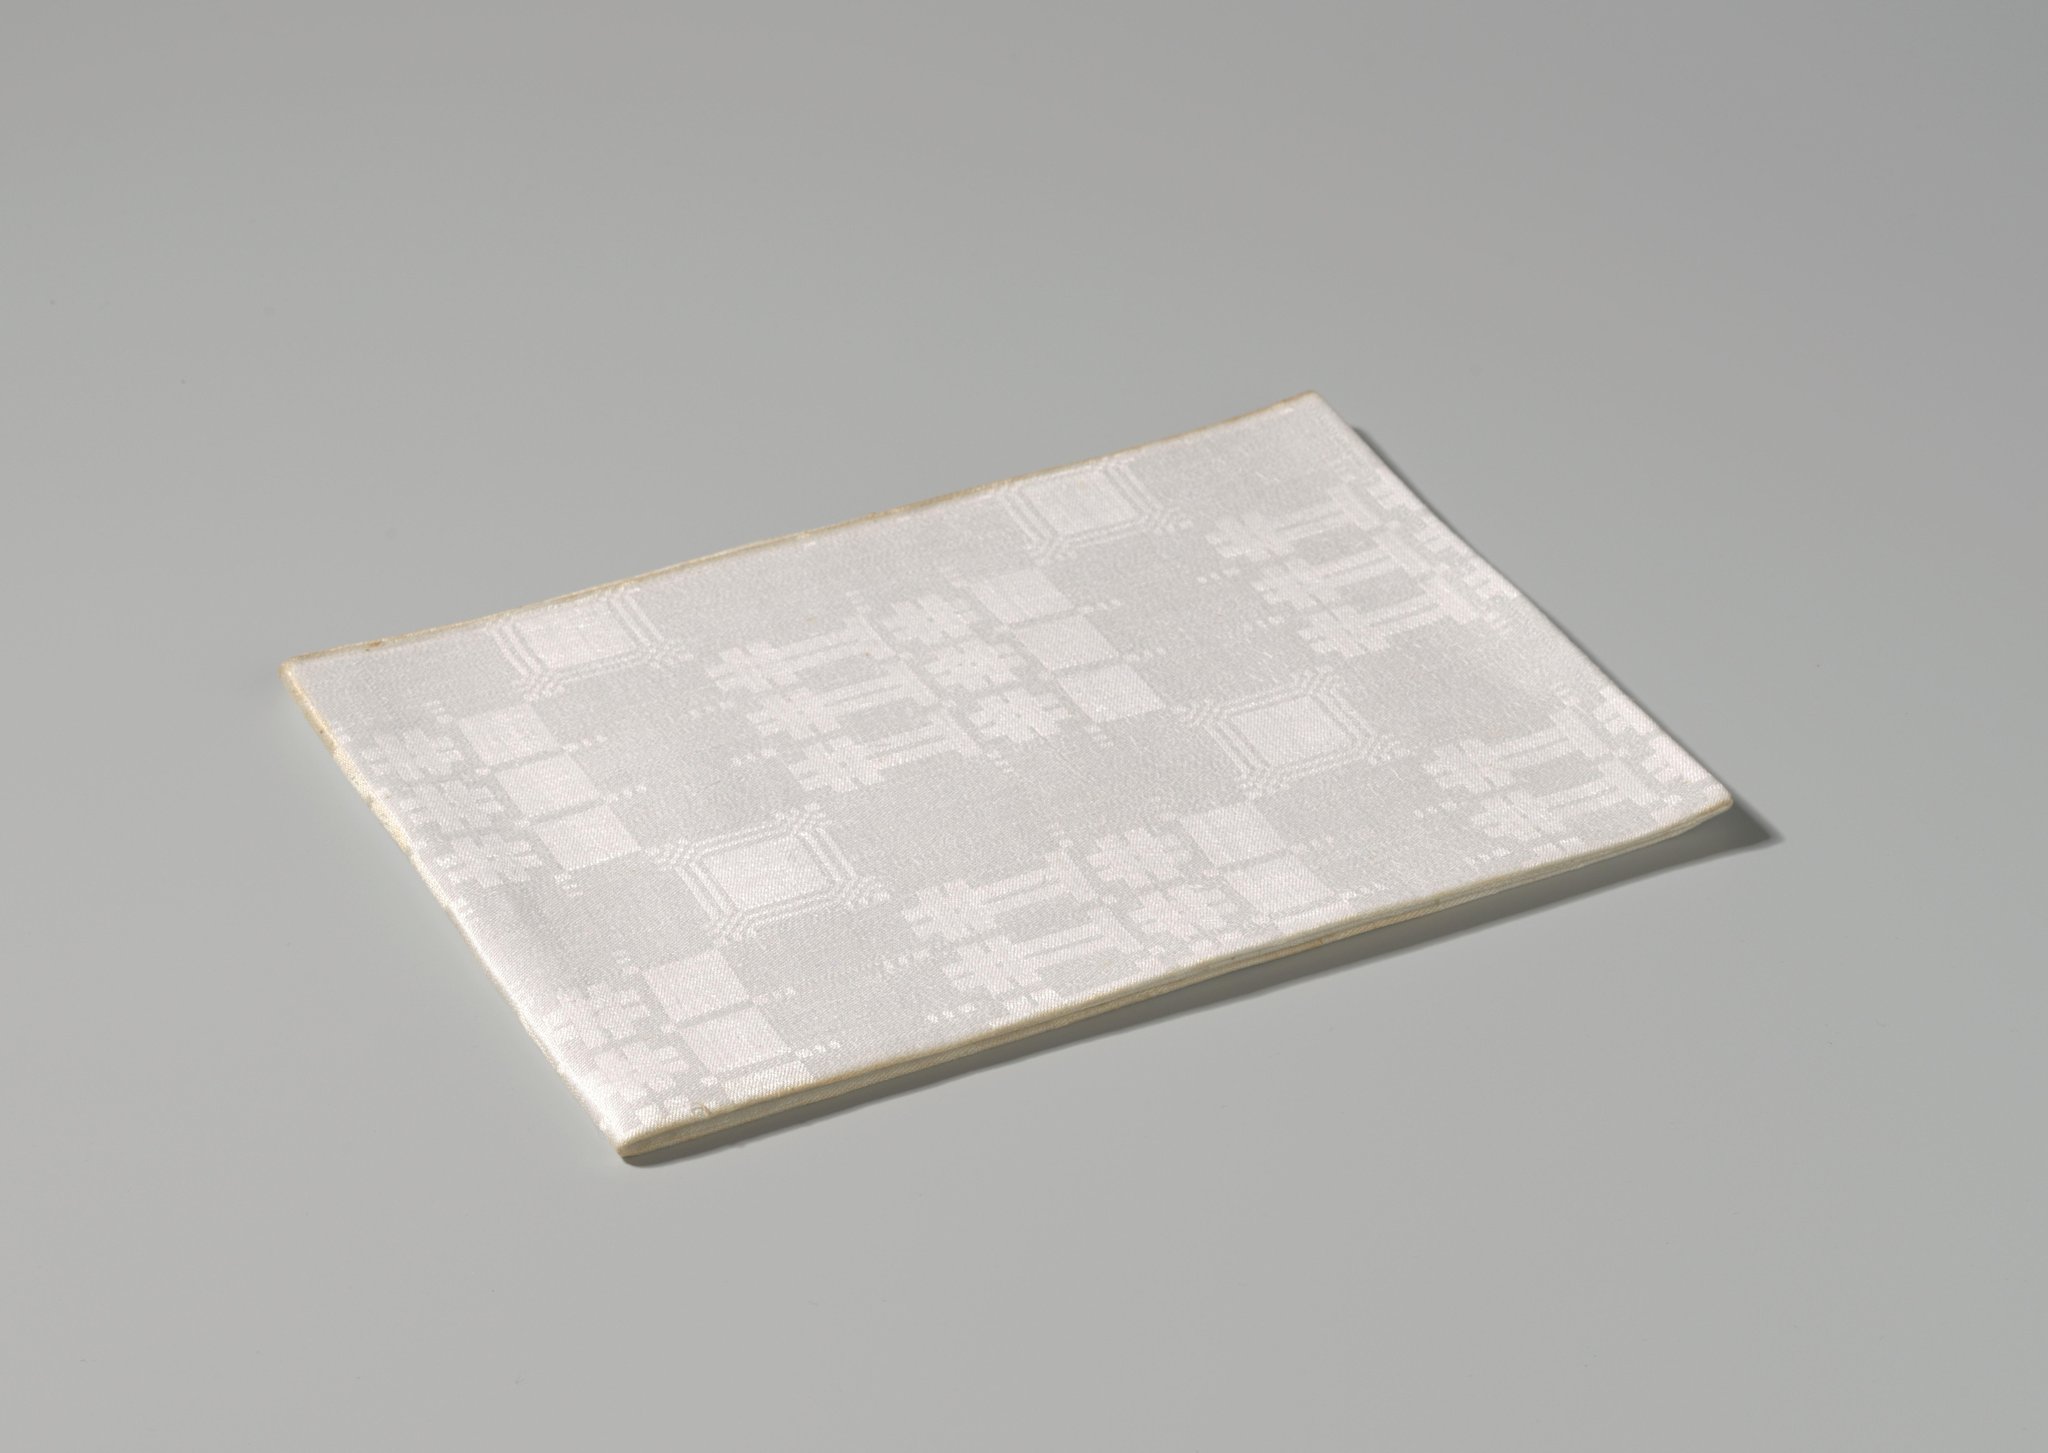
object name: napkin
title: Servet van linnen met pellenpatroon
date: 1725-1769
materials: linen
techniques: peeled fabric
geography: northern netherlands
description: wit linnen servet met pellen patroon, merk kroon ARVG 31